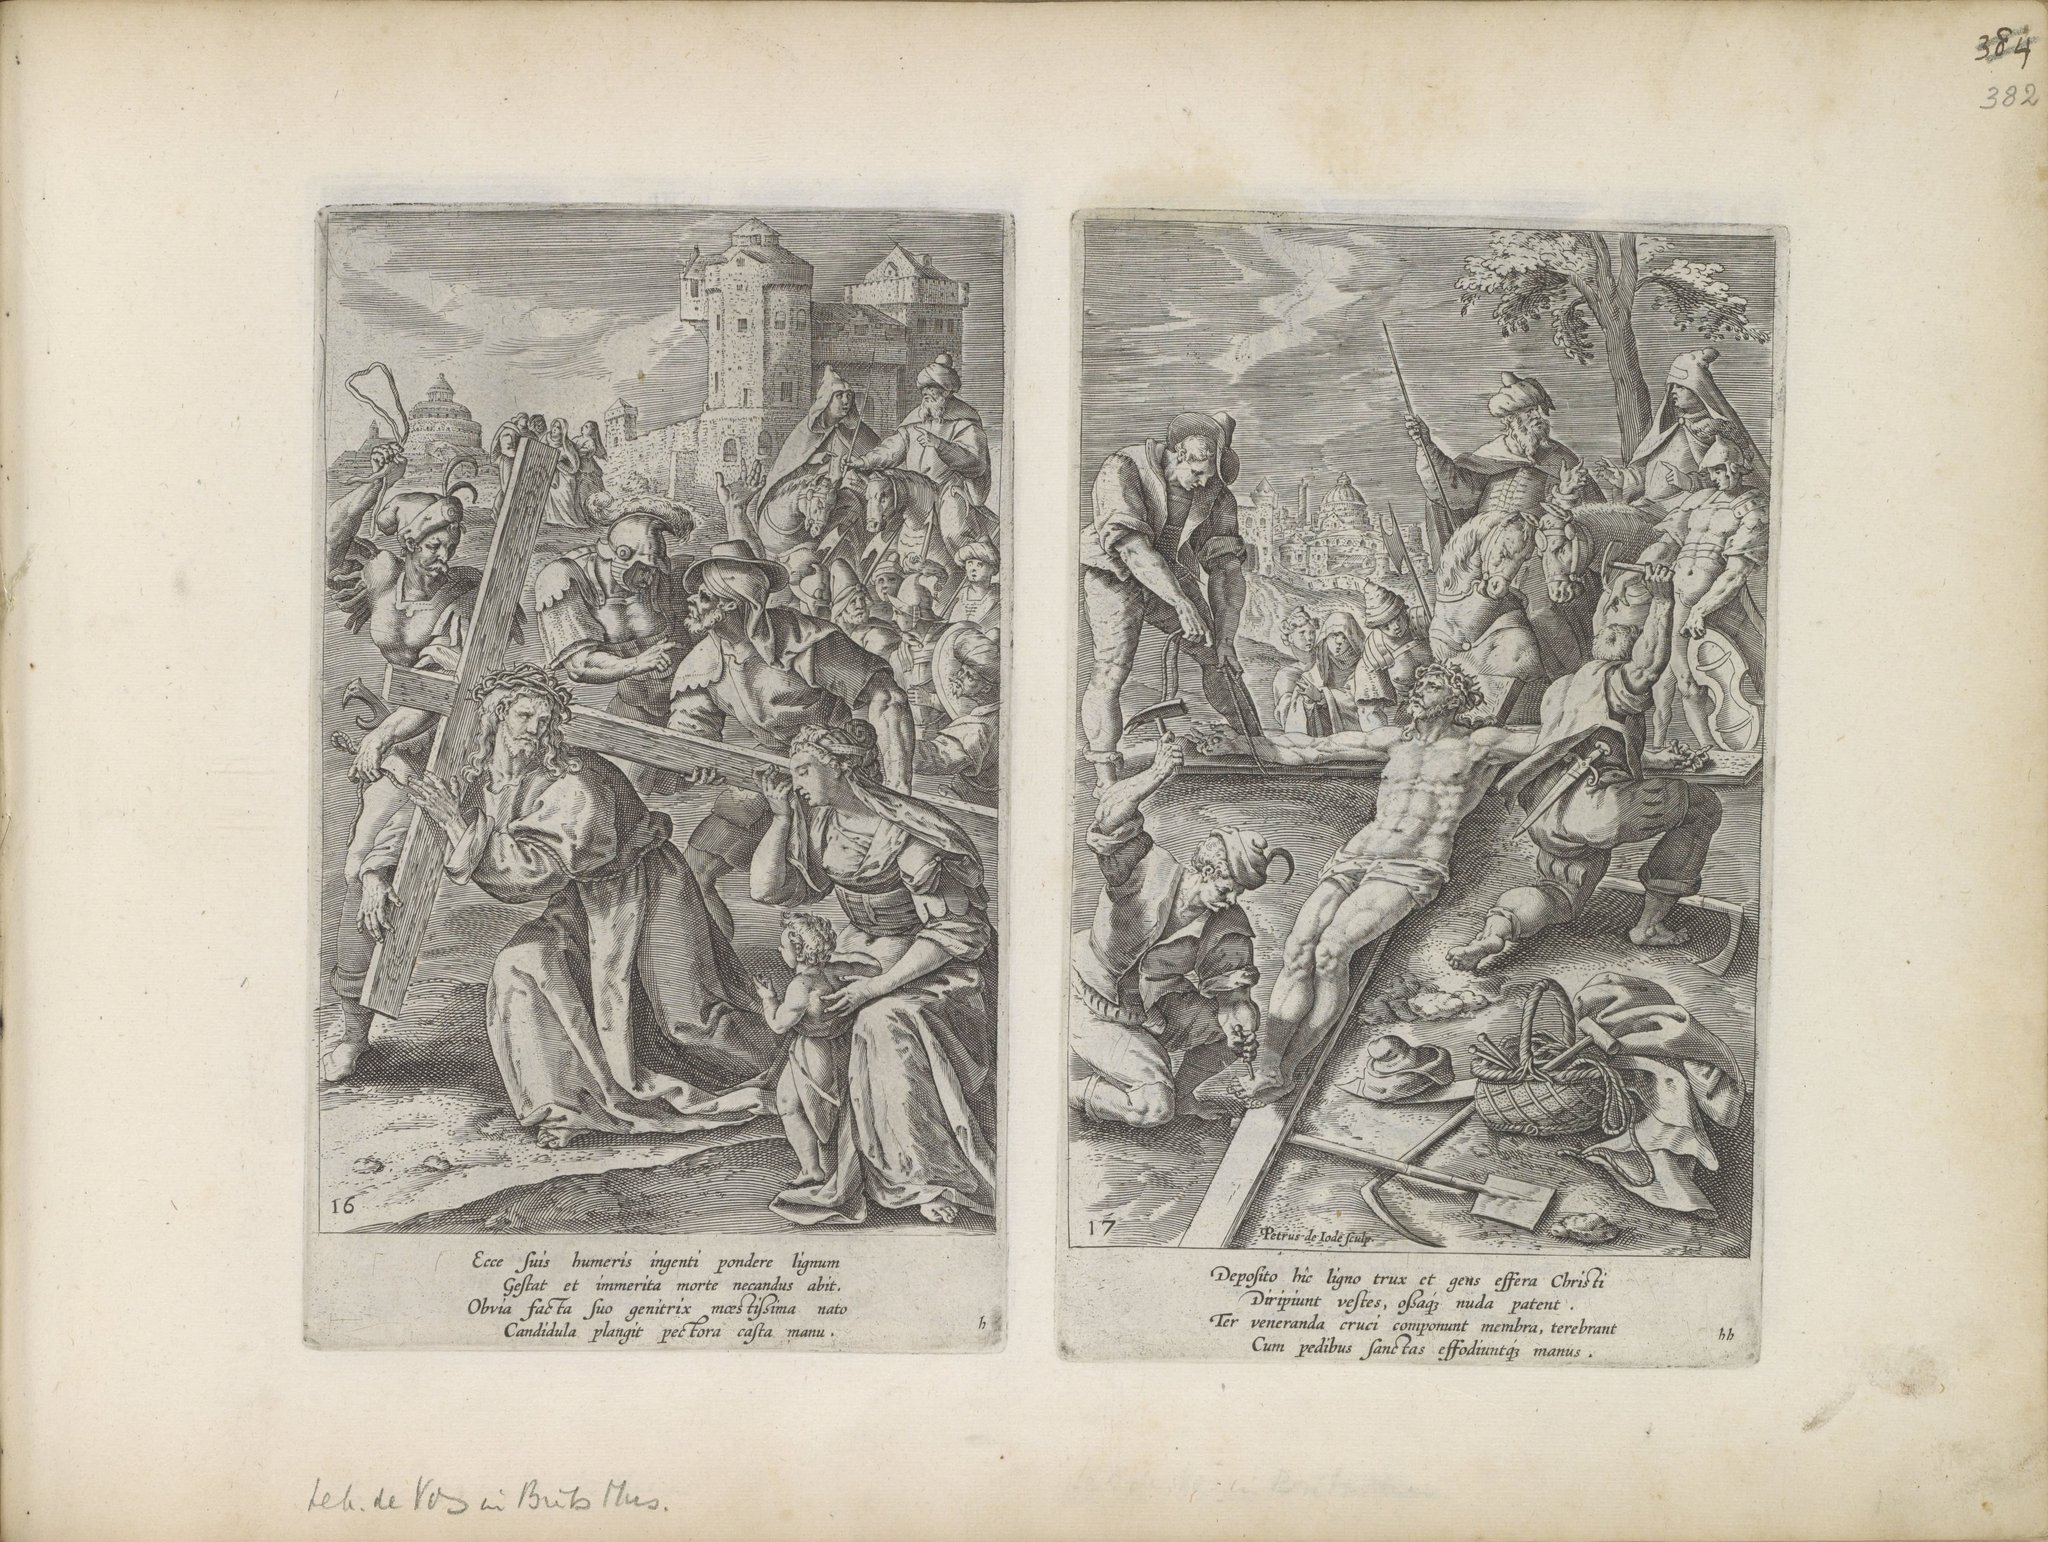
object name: album leaf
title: Christus wordt gekruisigd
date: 1585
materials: paper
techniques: engraving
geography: amsterdam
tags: the erection of the cross: christ is nailed to the cross which lies on the ground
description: Het kruis ligt op de grond. Soldaten nagelen Christus vast aan handen en voeten. Onder de voorstelling een vierregelig vers in het Latijn. Rechtsonder de letters: hh. Deze prent maakt deel uit van een album.